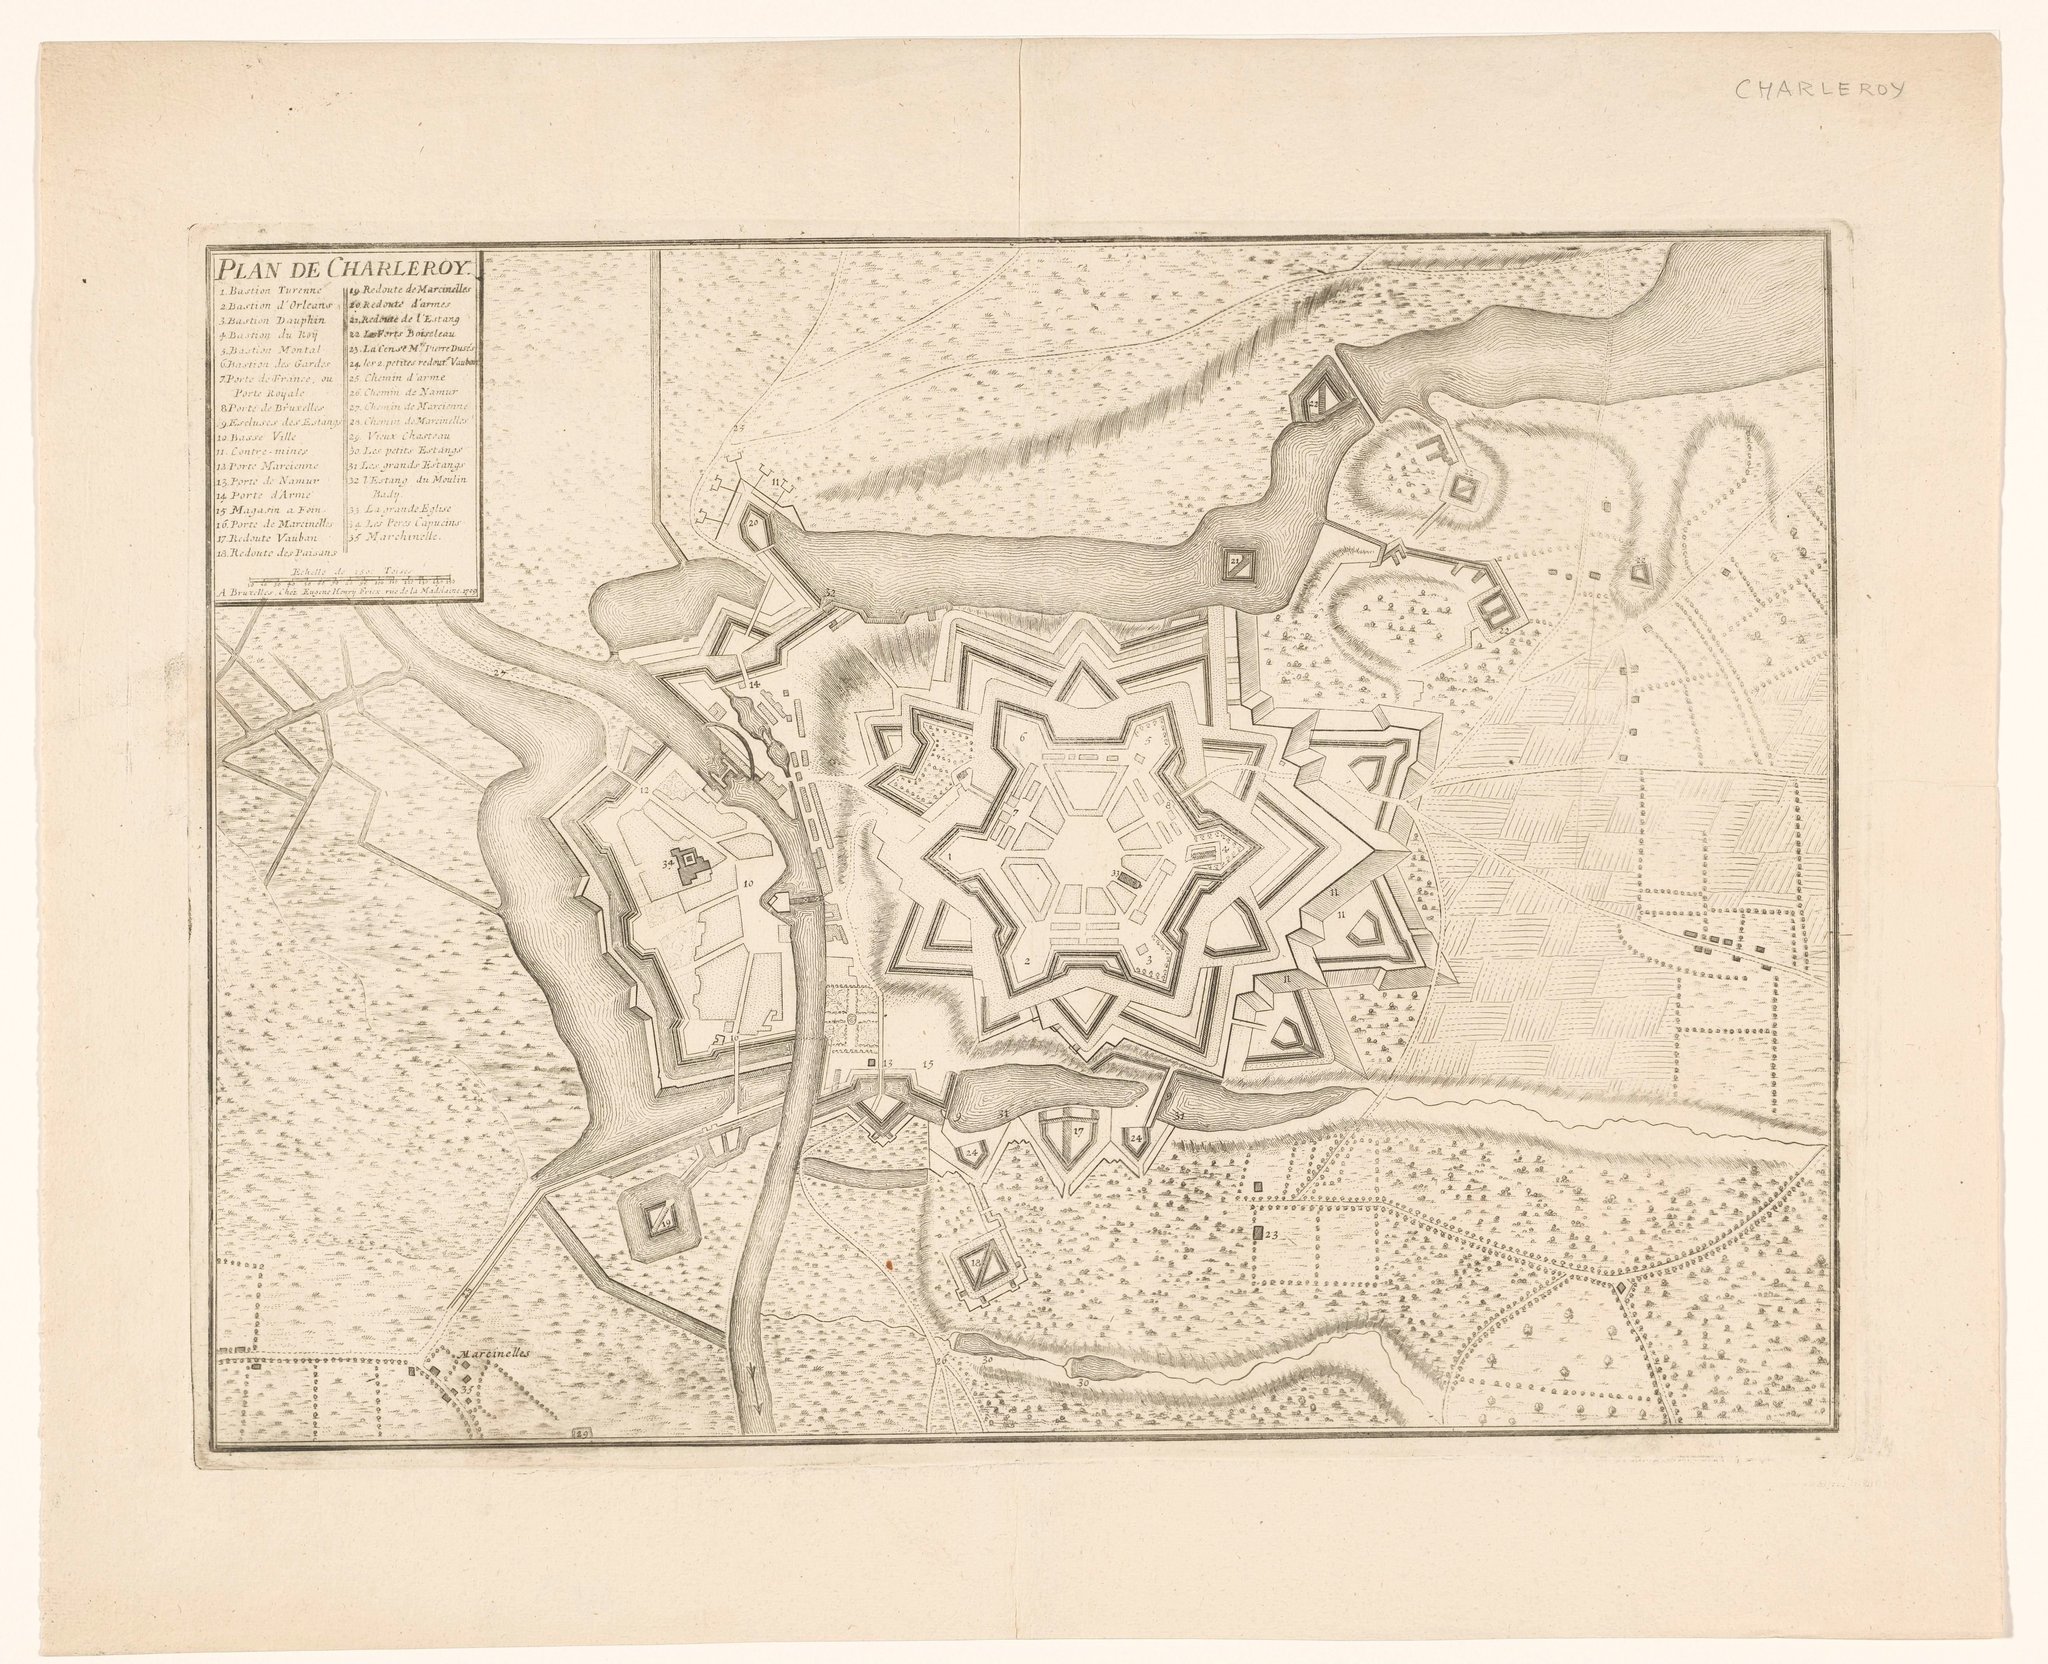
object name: area plan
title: Plan de Charleroy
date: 1709-1712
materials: paper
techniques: engraving, etching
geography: brussels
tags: fortified city, maps of cities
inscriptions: collector's mark: Lugt 2228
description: Vestingplattegrond van Charleroi. Linksboven een cartouche met titel, legenda 1-35 en schaalstok: Echelle de 150 Toises.